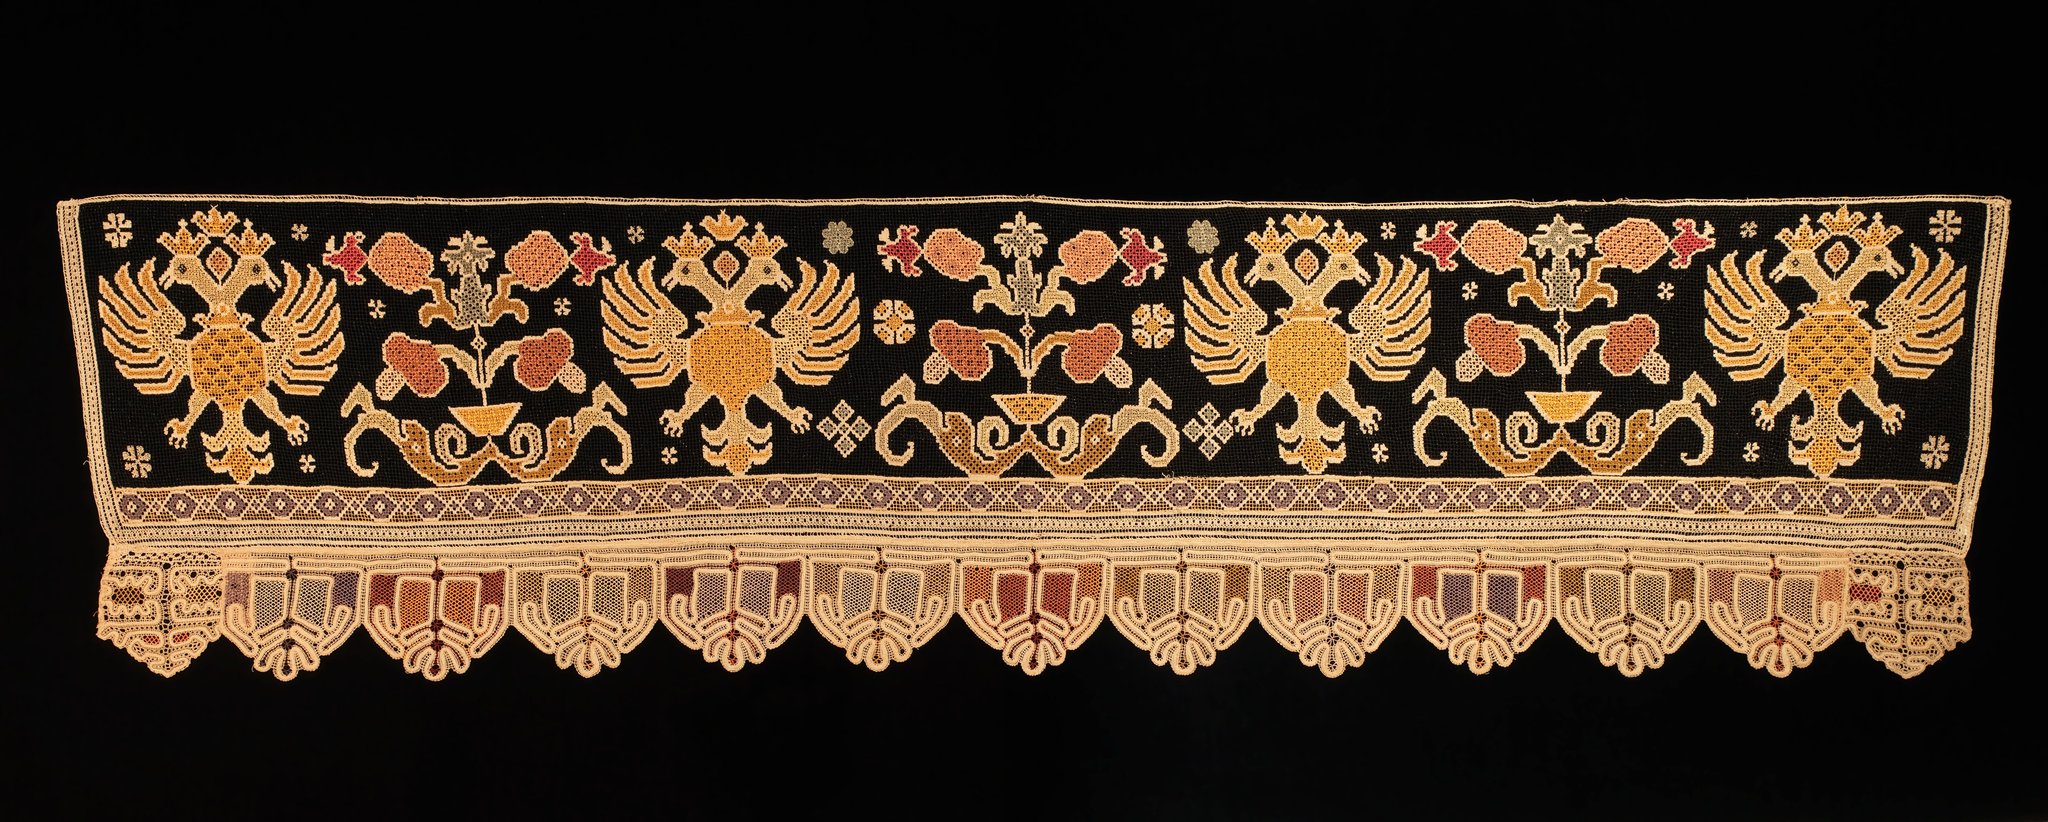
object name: border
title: Bed curtain border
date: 1801-1833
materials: linen, silk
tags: eagles